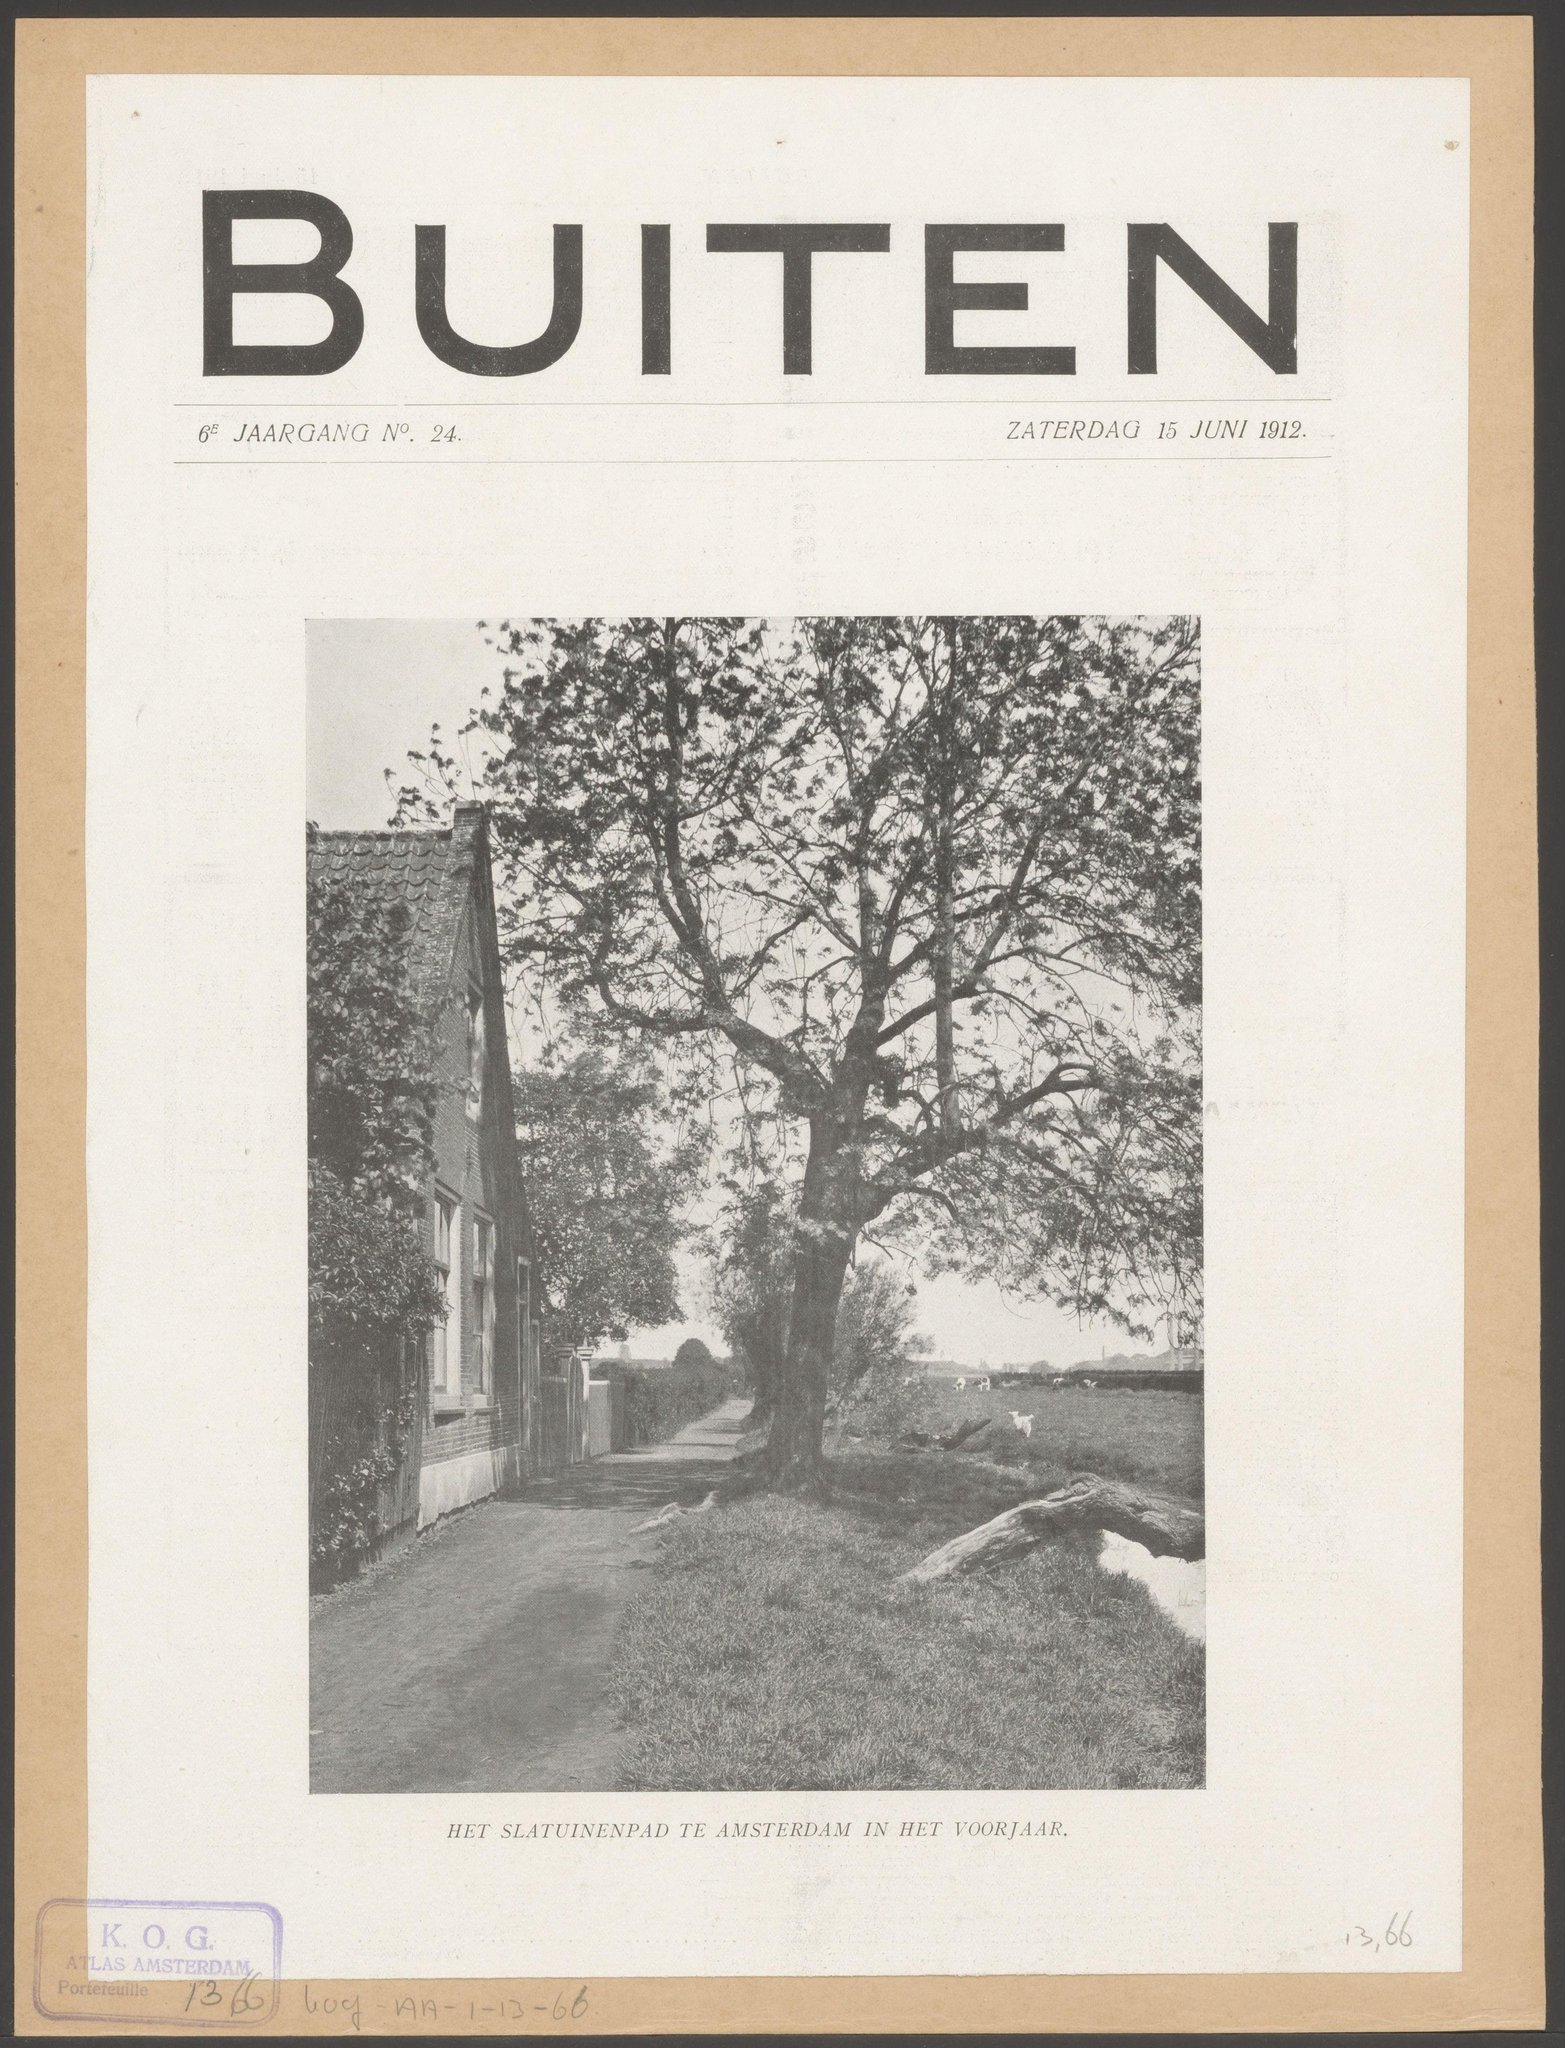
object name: titelblad, titelpagina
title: Titelpagina voor: Buiten, 15 juni 1912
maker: Anonymous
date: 1912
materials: paper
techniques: letterpress printing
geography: amsterdam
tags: city-view in general; 'veduta', road, path, farm or solitary house in landscape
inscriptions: collector's mark: ‘13,66’ Lugt 1641b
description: Onderwerpsrubriek binnen de Atlas Amsterdam: Slatuinenpad, Sloterkade, Slootstraat, Slijkstraat, Snoekjesgracht, Sophiapark, Spaarndammerdijk, Spiegelgracht, Spinhuissteeg, Spui, Spuistraat (ook lage Erf), Staalstraat, Stadhouderskade, Steenpad, Stroomarkt.